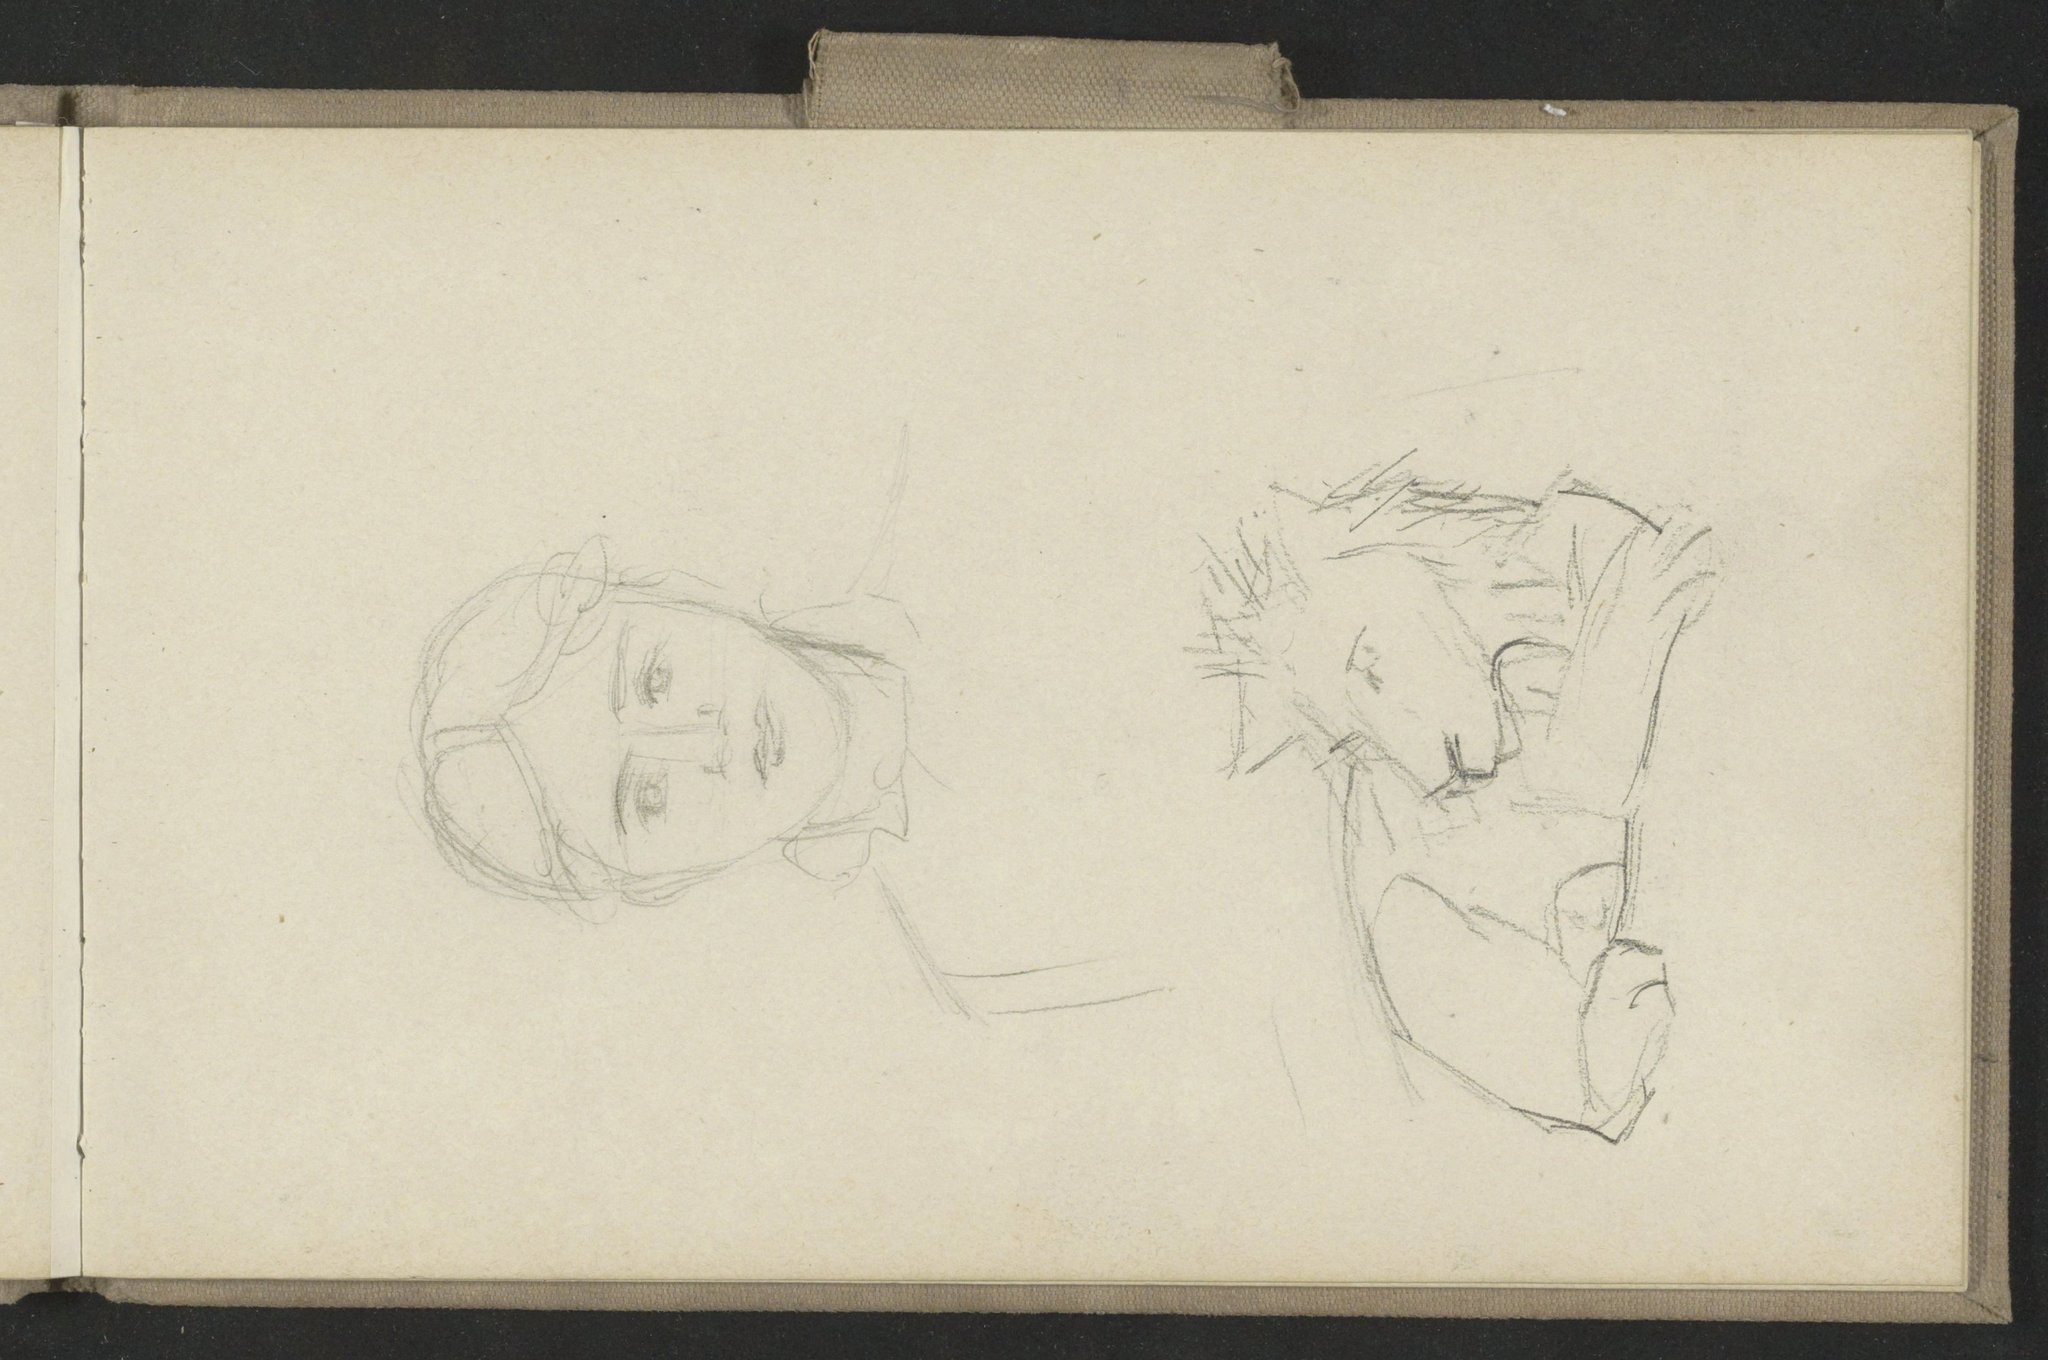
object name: sketchbook leaf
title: Kop van een meisje en een liggende leeuw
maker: jozef israëls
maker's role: draughtsman, painter, print maker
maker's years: 1824-1911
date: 1834-1911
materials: paper, pencil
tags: head (human) (+ young female (human being)), beasts of prey, predatory animals: lion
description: Blad 20 recto uit een schetsboek met 26 bladen.